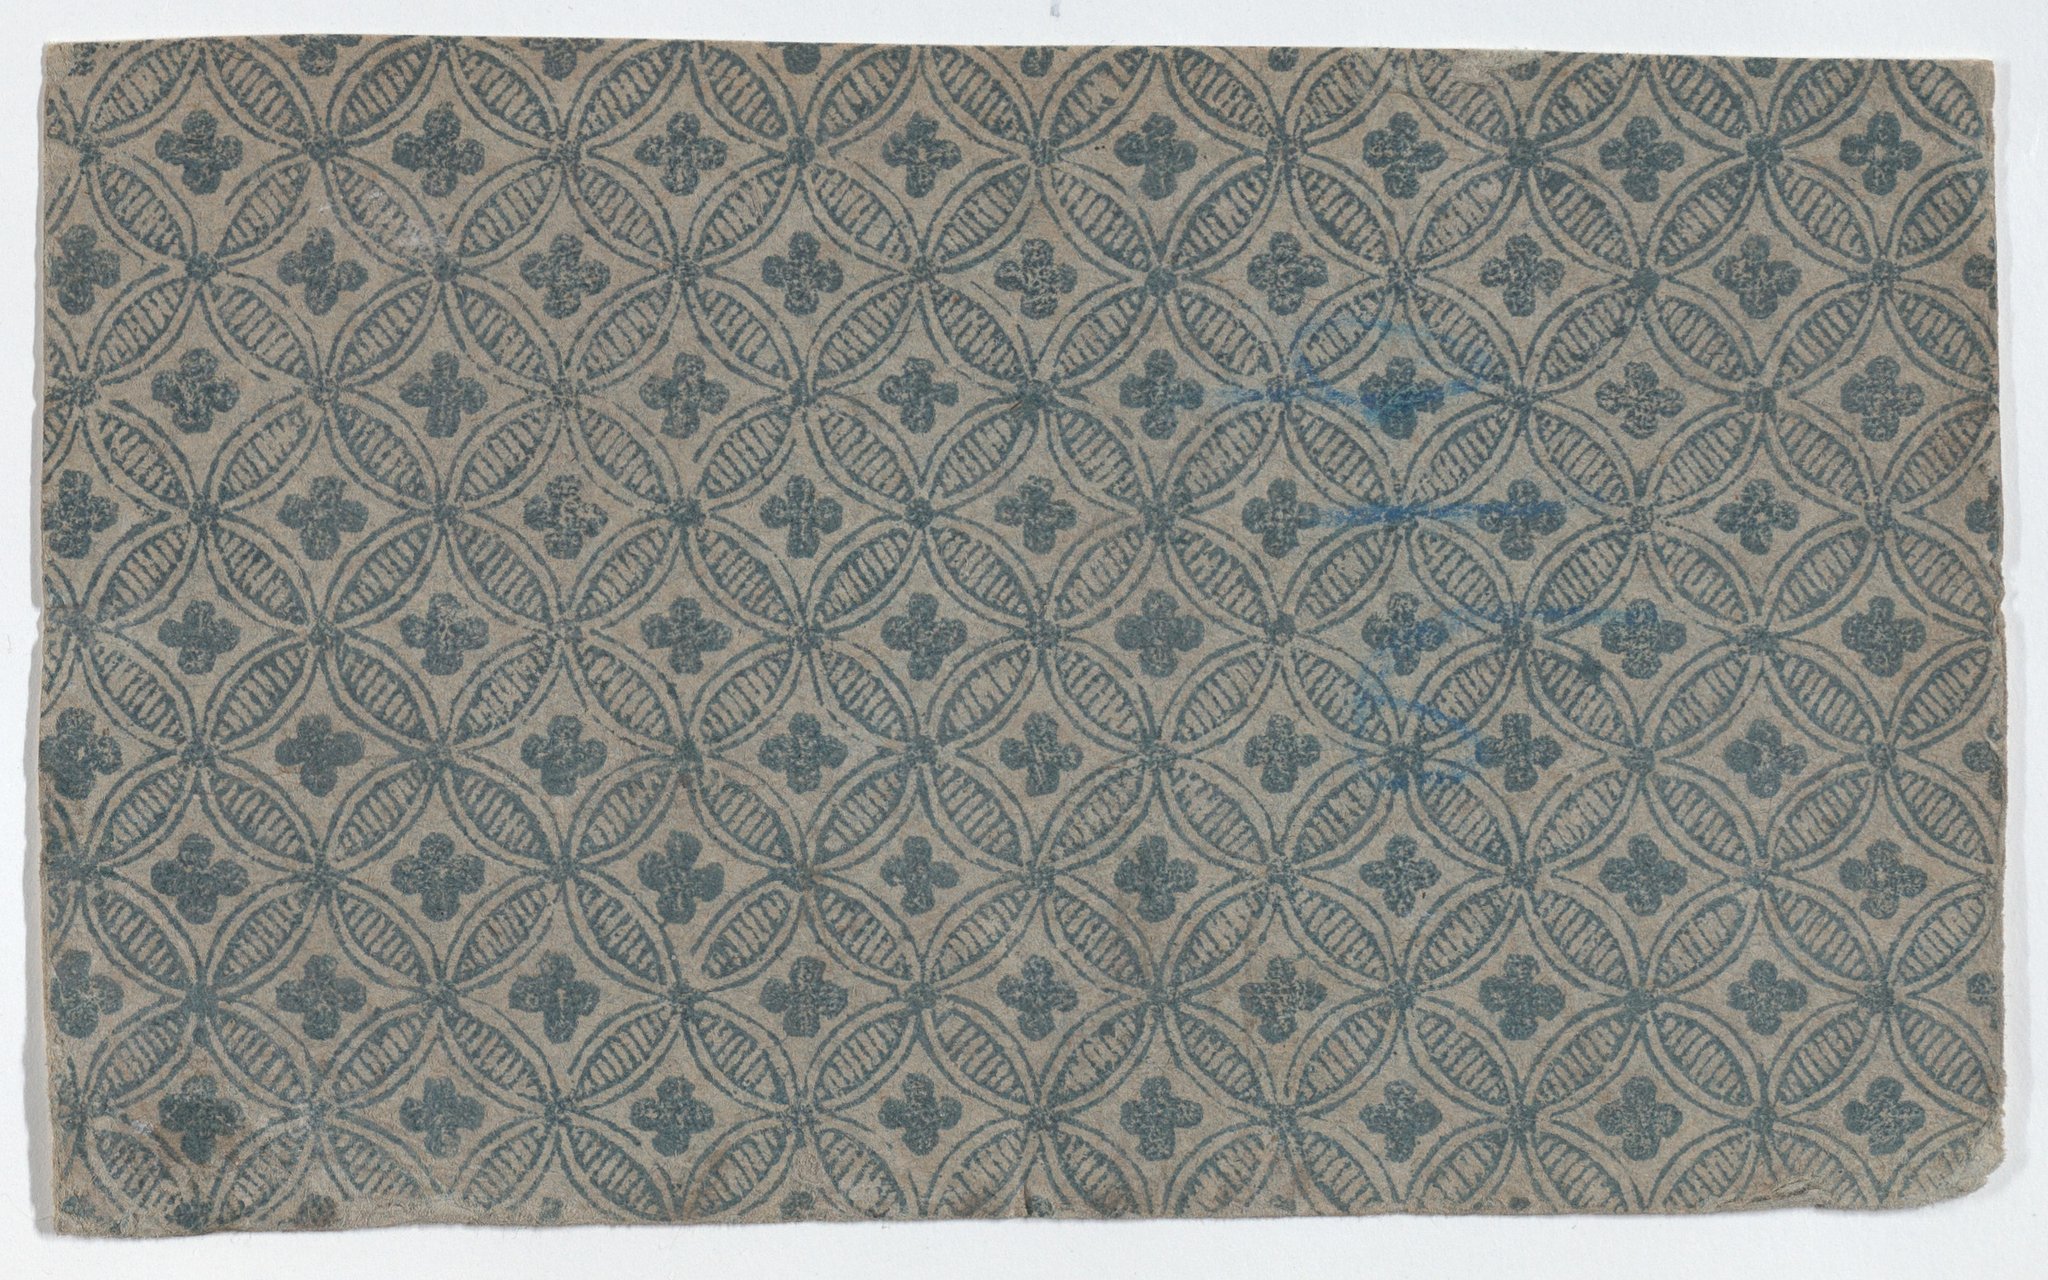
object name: print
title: Sheet with pattern of overlapping circles with clover shapes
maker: Anonymous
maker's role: artist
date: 1801-1900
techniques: relief print